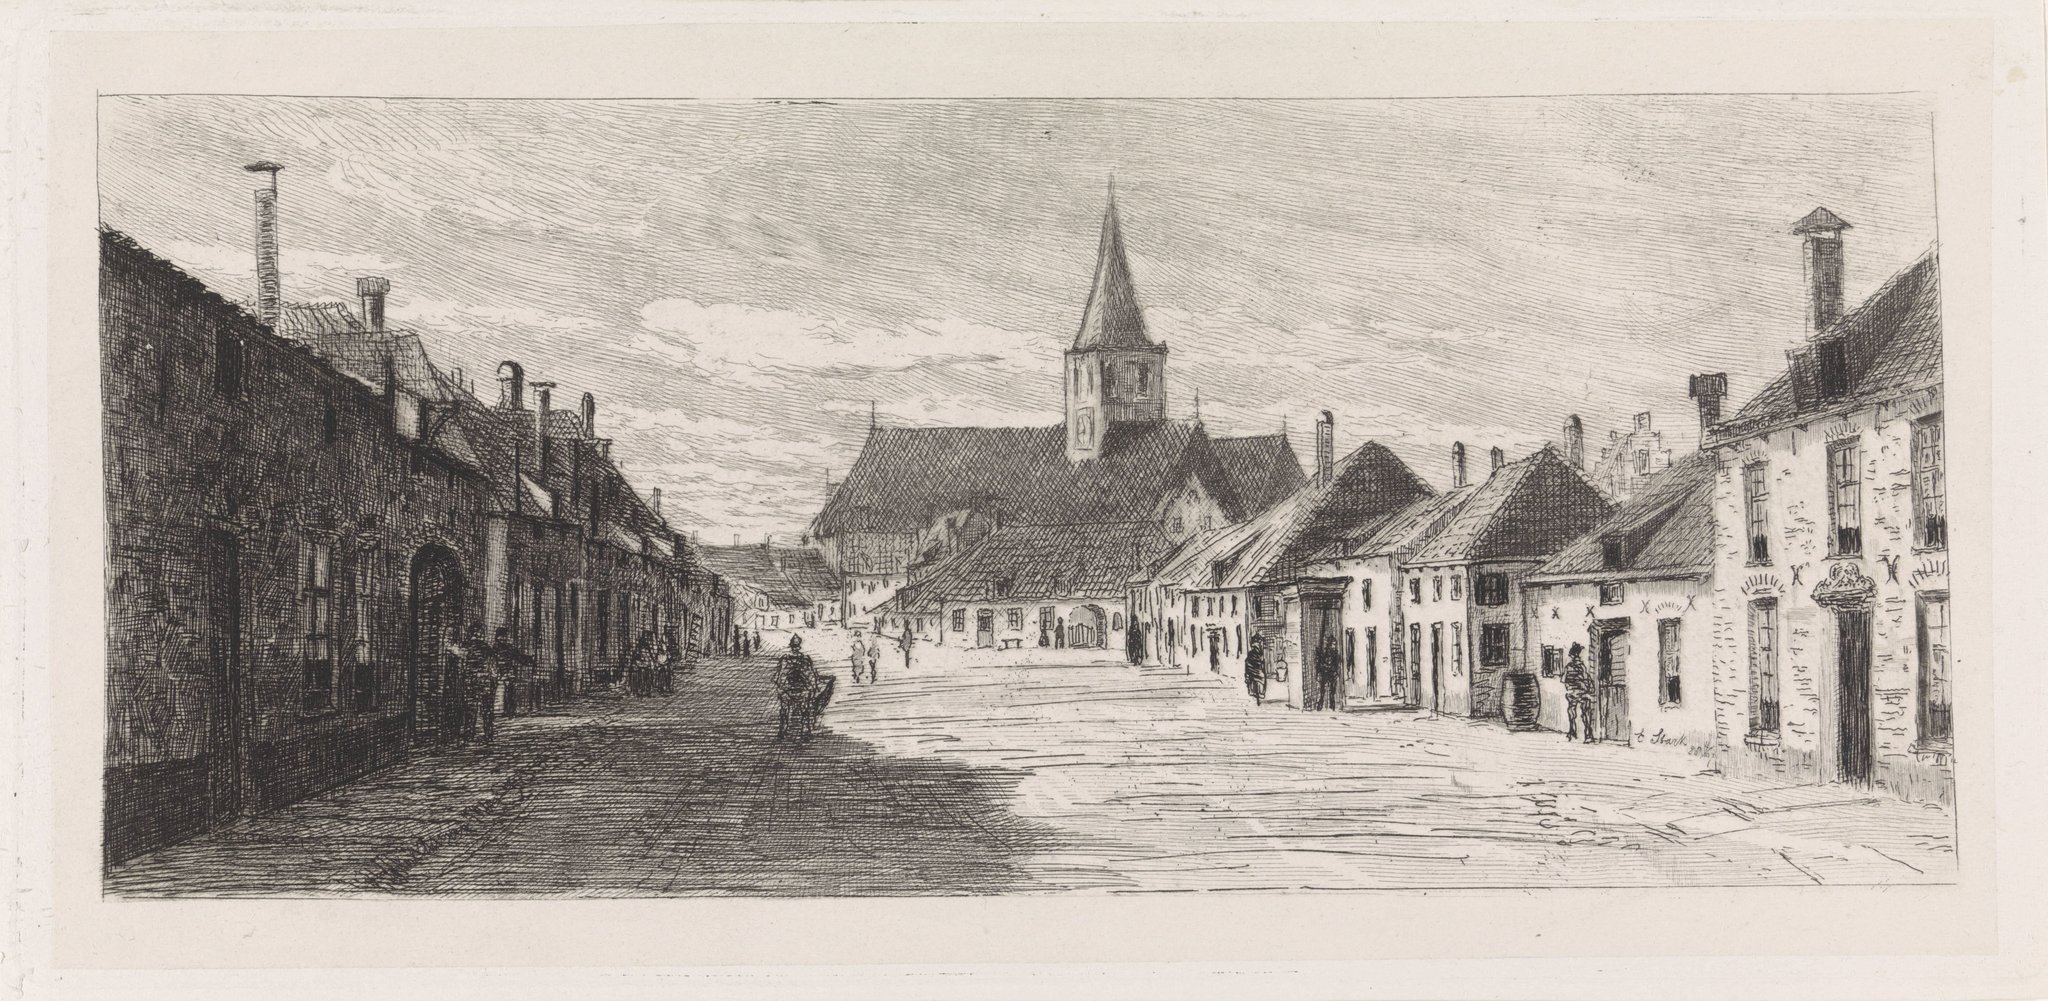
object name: print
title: Straat in Amersfoort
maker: elias stark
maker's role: draughtsman, print maker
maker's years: 1849-1933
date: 1887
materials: paper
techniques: drypoint, etching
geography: nieuwer-amstel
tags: village street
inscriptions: collector's mark: Lugt 2228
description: Straat in de stad Amersfoort met aan het einde de Sint-Joriskerk.